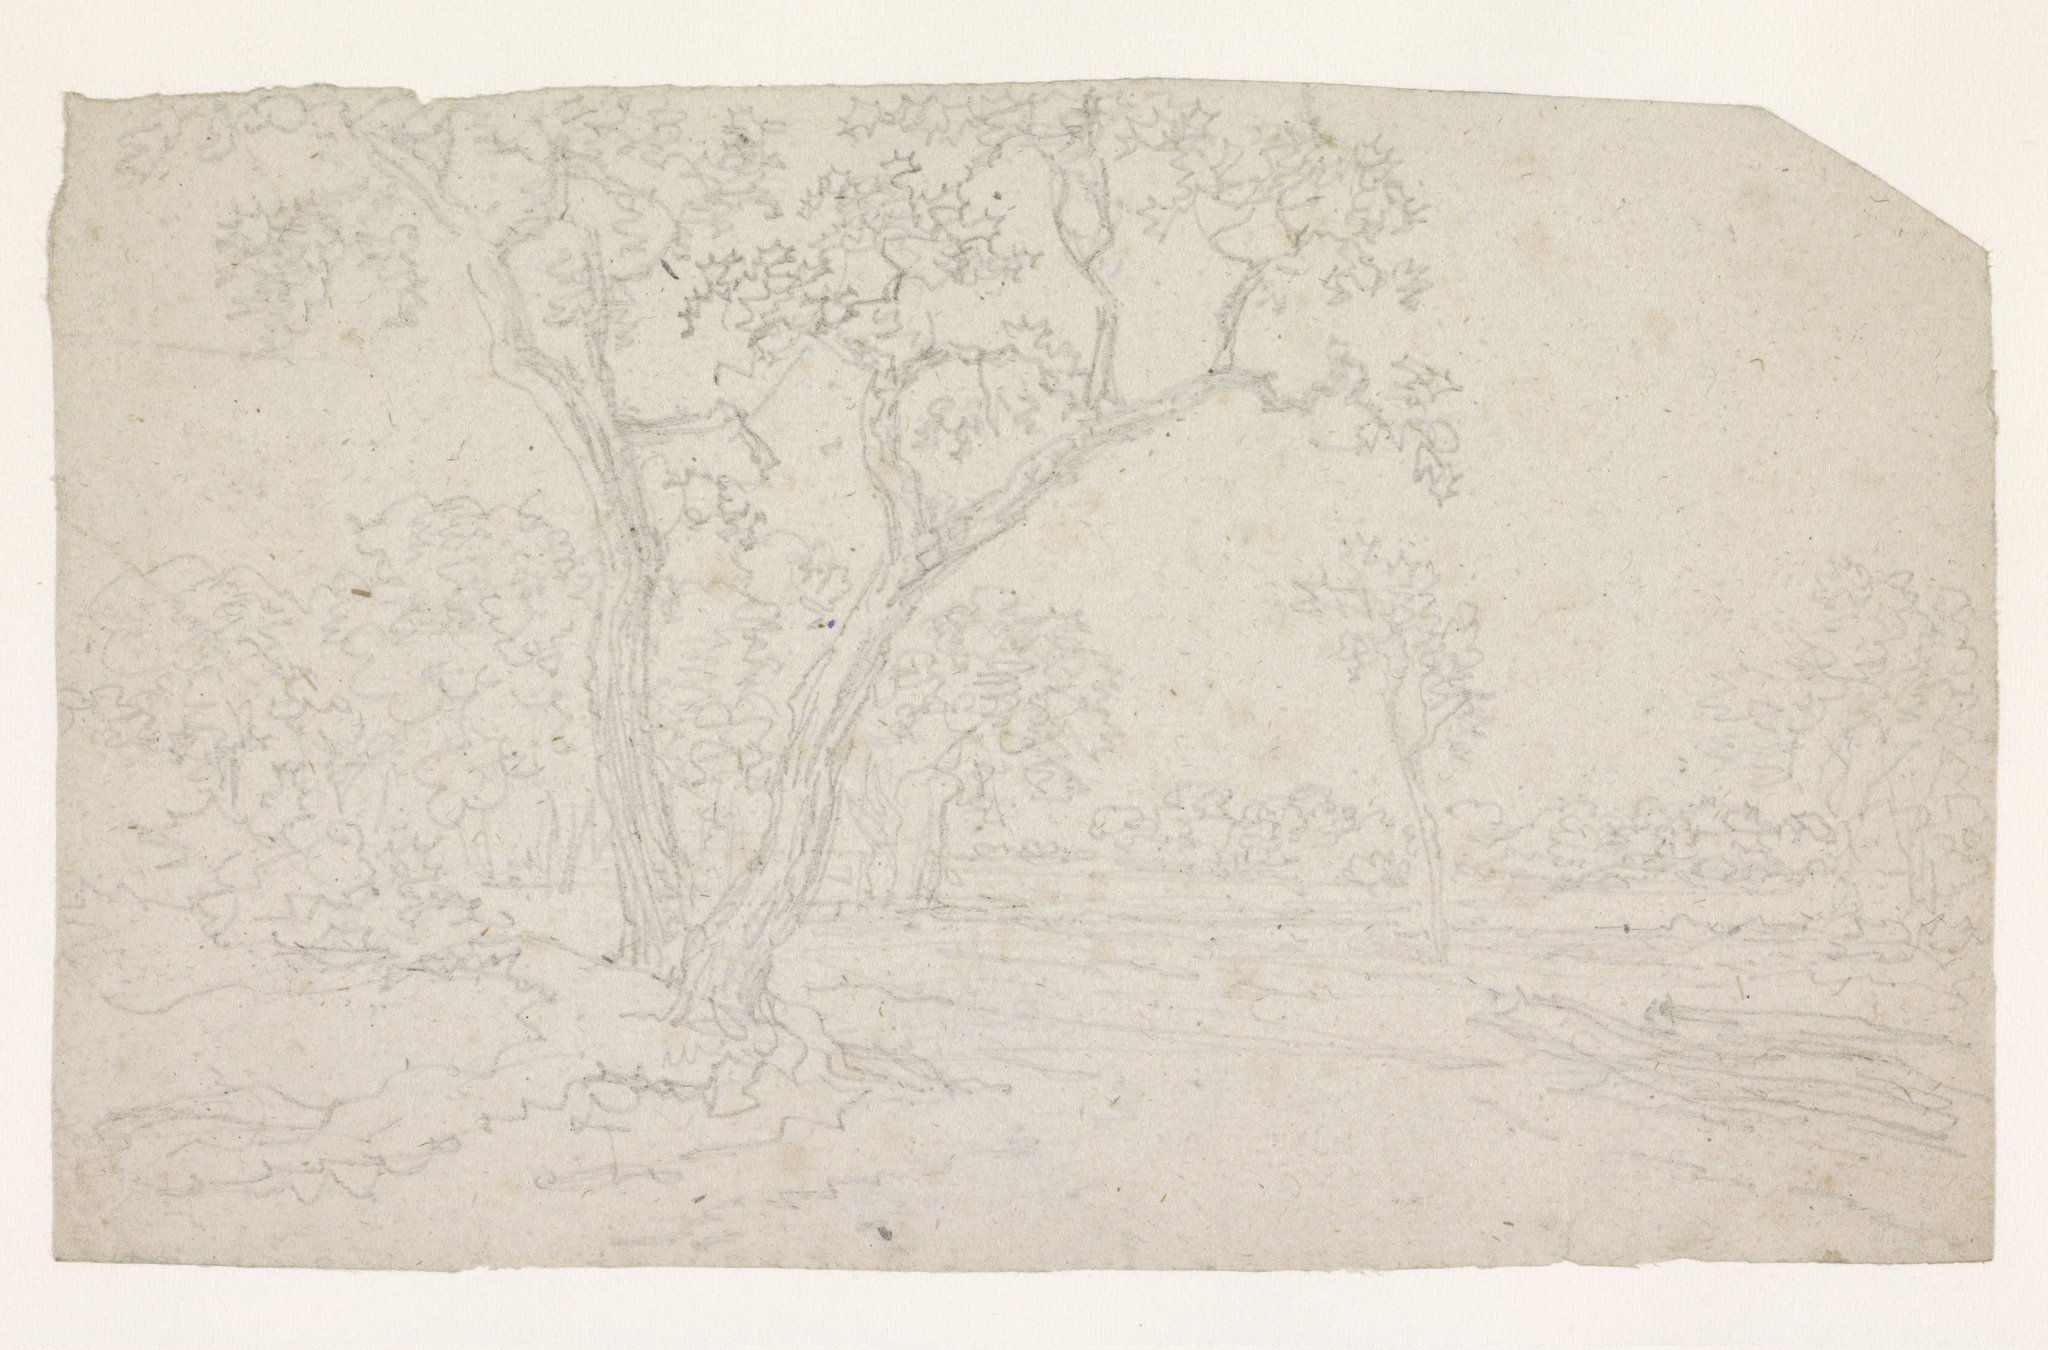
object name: drawing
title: Bomen in een vlak landschap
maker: georges michel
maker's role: draughtsman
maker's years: 1763-1843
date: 1773-1843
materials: paper, pencil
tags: groups of trees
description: Een van 120 tekeningen, afkomstig uit een 19e eeuws album met tekeningen van Georges Michel.